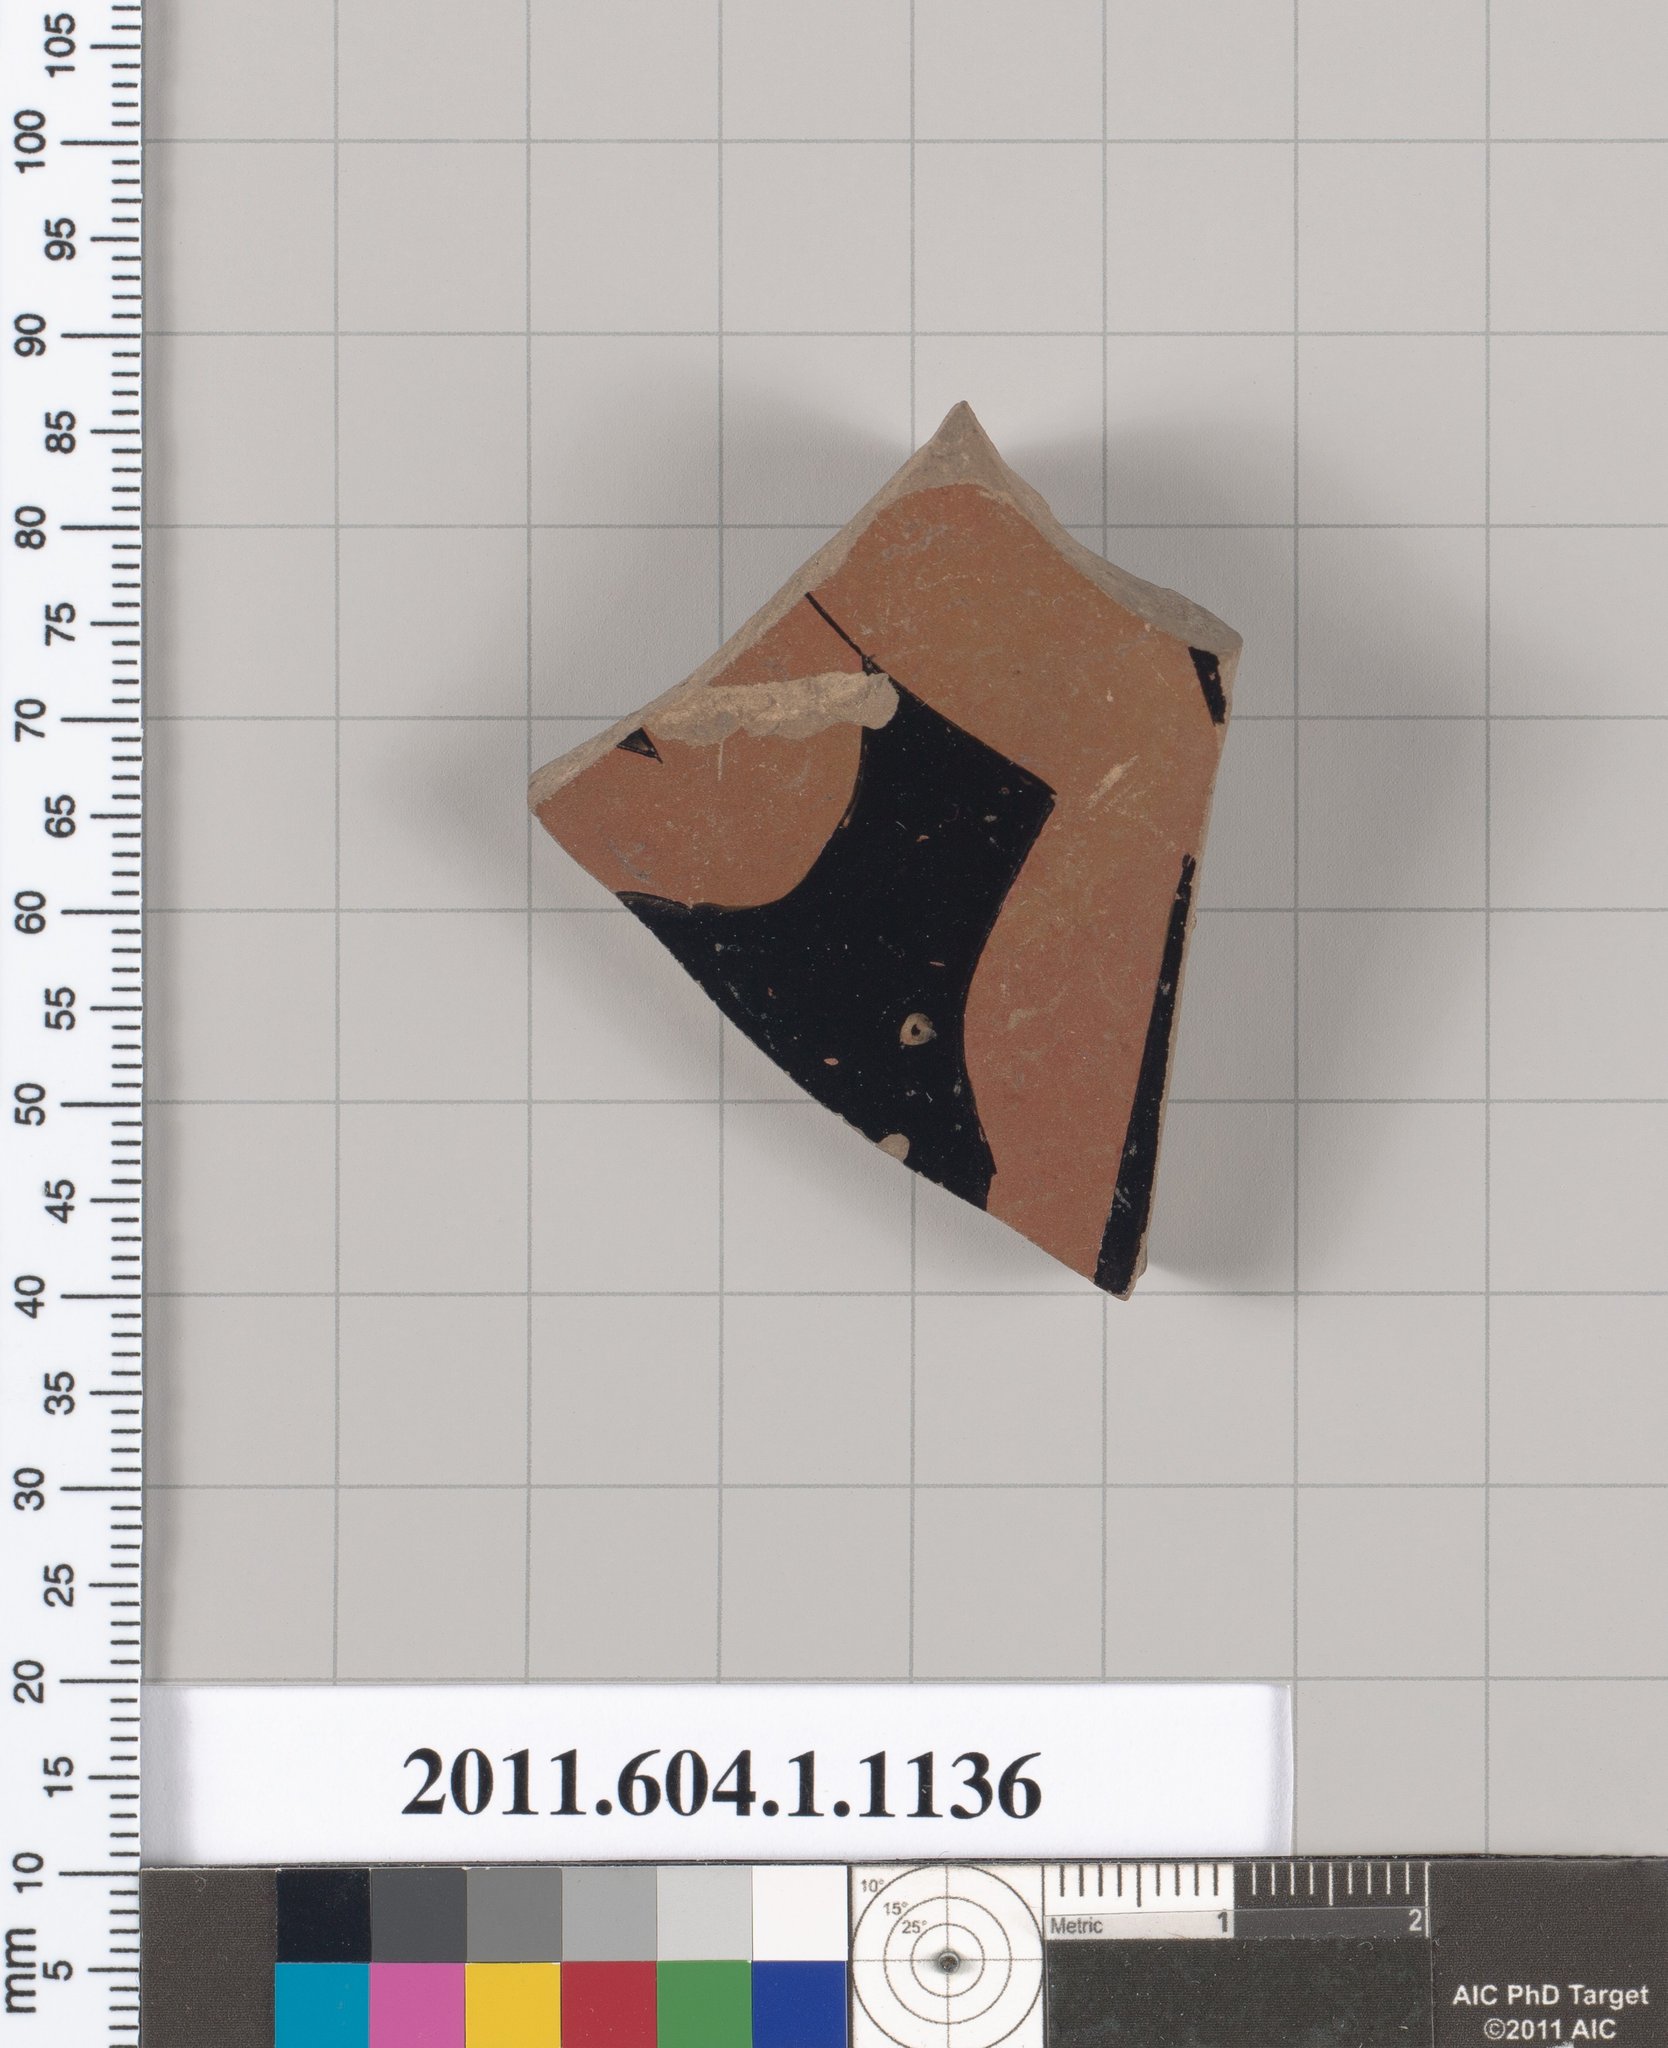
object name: kylix fragment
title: Terracotta fragment of a kylix (drinking cup)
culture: greek, attic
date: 490-480 BCE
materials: terracotta